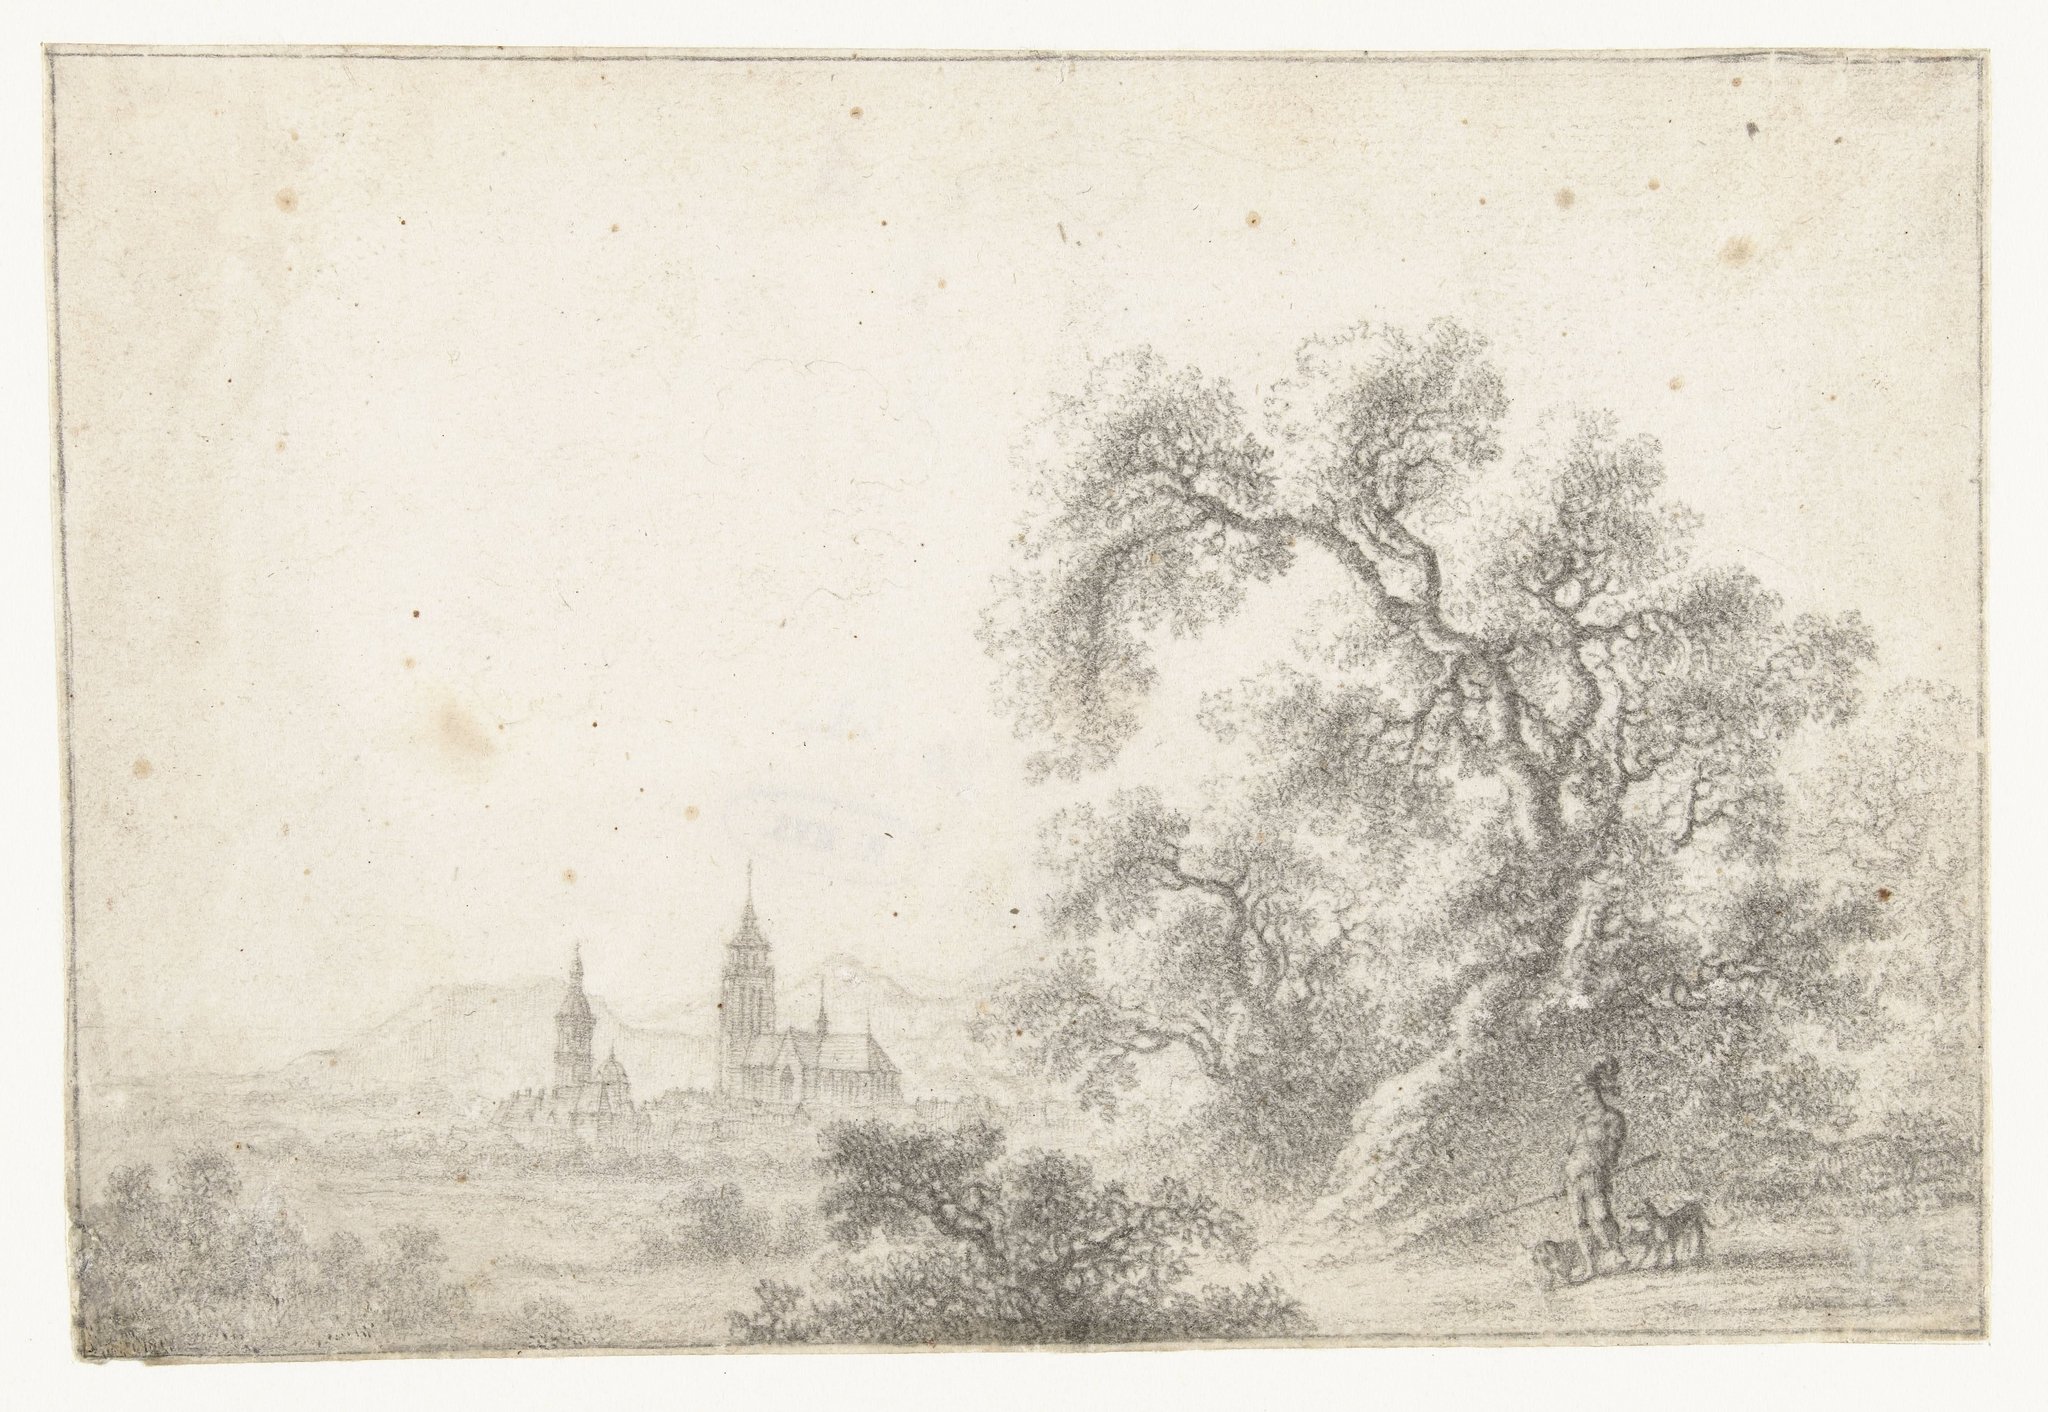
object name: drawing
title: Landschap met jager en in de verte een stad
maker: gilles neyts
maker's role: draughtsman, print maker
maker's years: 1623-1687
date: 1633-1687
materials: chalk, paper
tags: landscapes in the temperate zone